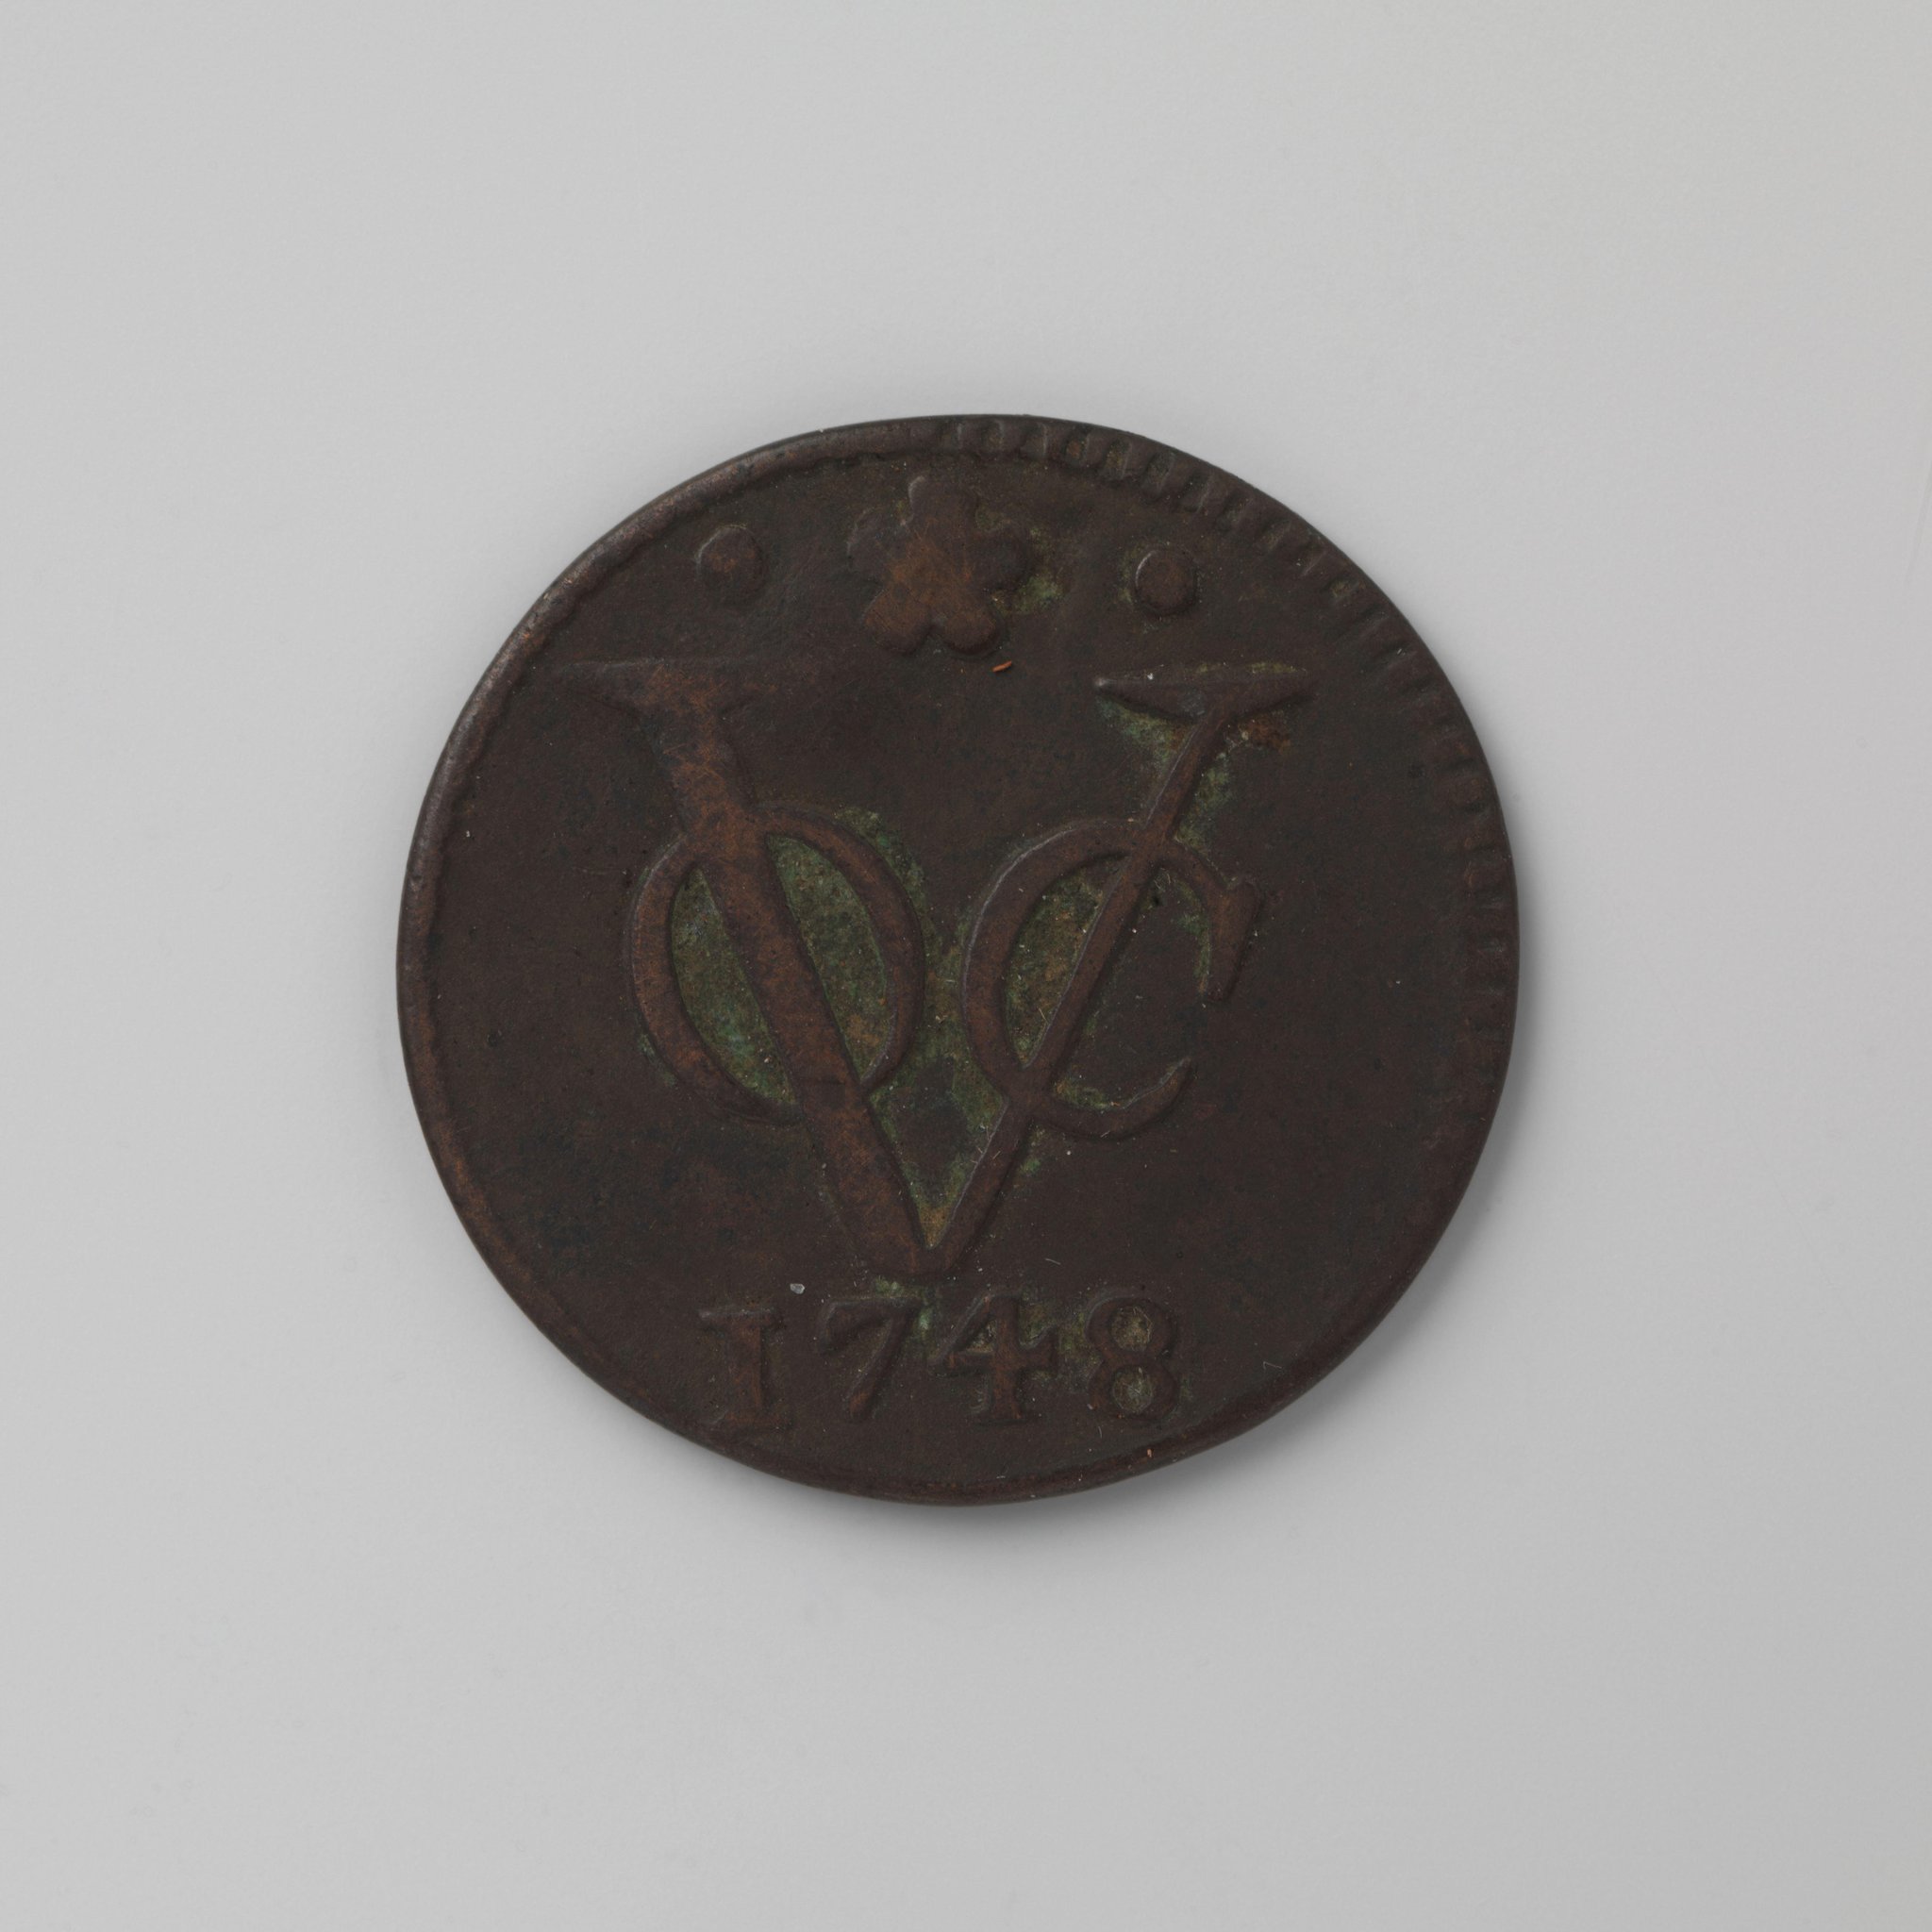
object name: coin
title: VOC, duit Holland, 1748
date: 1748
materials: copper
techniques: striking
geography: dordrecht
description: Koperen munt. Voorzijde: gekroond wapenschild van Holland. Keerzijde: monogram van de VOC, waarboven muntteken en waaronder jaartal. Gladde rand.